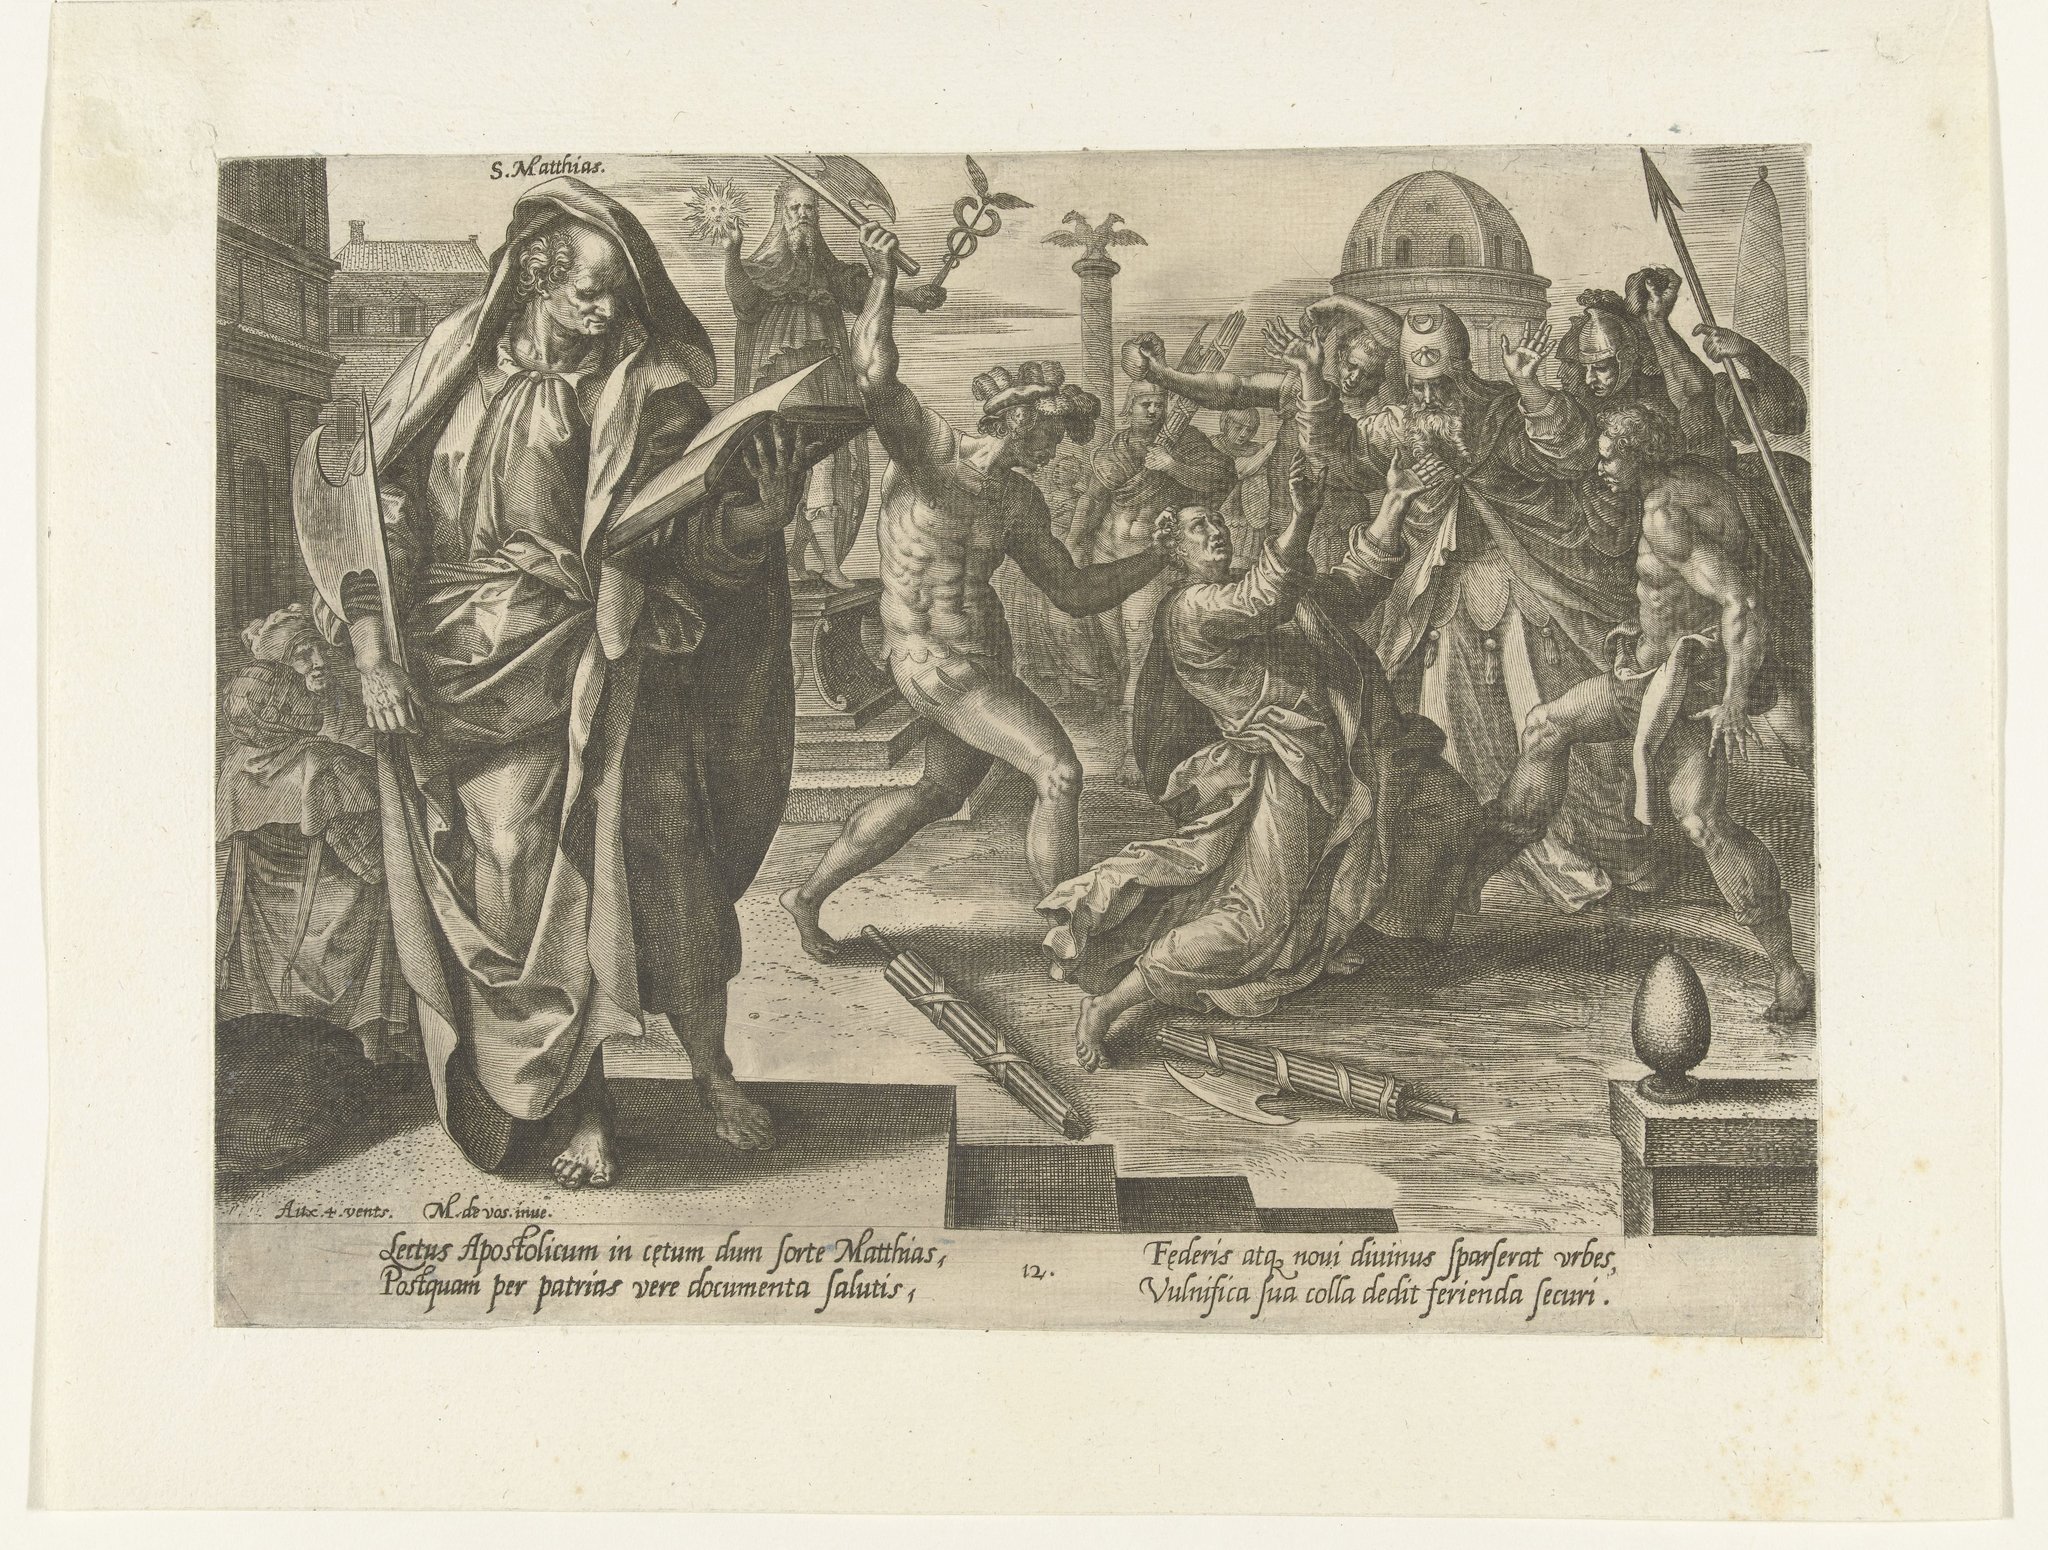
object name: print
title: Het martelaarschap van Christus en de apostelen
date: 1577-1582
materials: paper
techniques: engraving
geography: antwerp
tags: matthias stoned and beheaded, the apostle and martyr matthias; possible attributes: axe, book, cross, halberd, scroll, sword - martyrdom, suffering, misfortune, death of male saint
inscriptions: collector's mark: Lugt 240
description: Matthias wordt onthoofd met een bijl en gestenigd; links naast het tafereel van zijn marteldood staat hij nogmaals afgebeeld, met een bijl in de ene hand en een boek in de andere. Onder de voorstelling tweemaal twee regels Latijn. Deze prent is onderdeel van een serie van 13 prenten van Christus (ongenummerd) en de apostelen (genummerd), meer specifiek van de martelingen die ze hebben ondergaan.